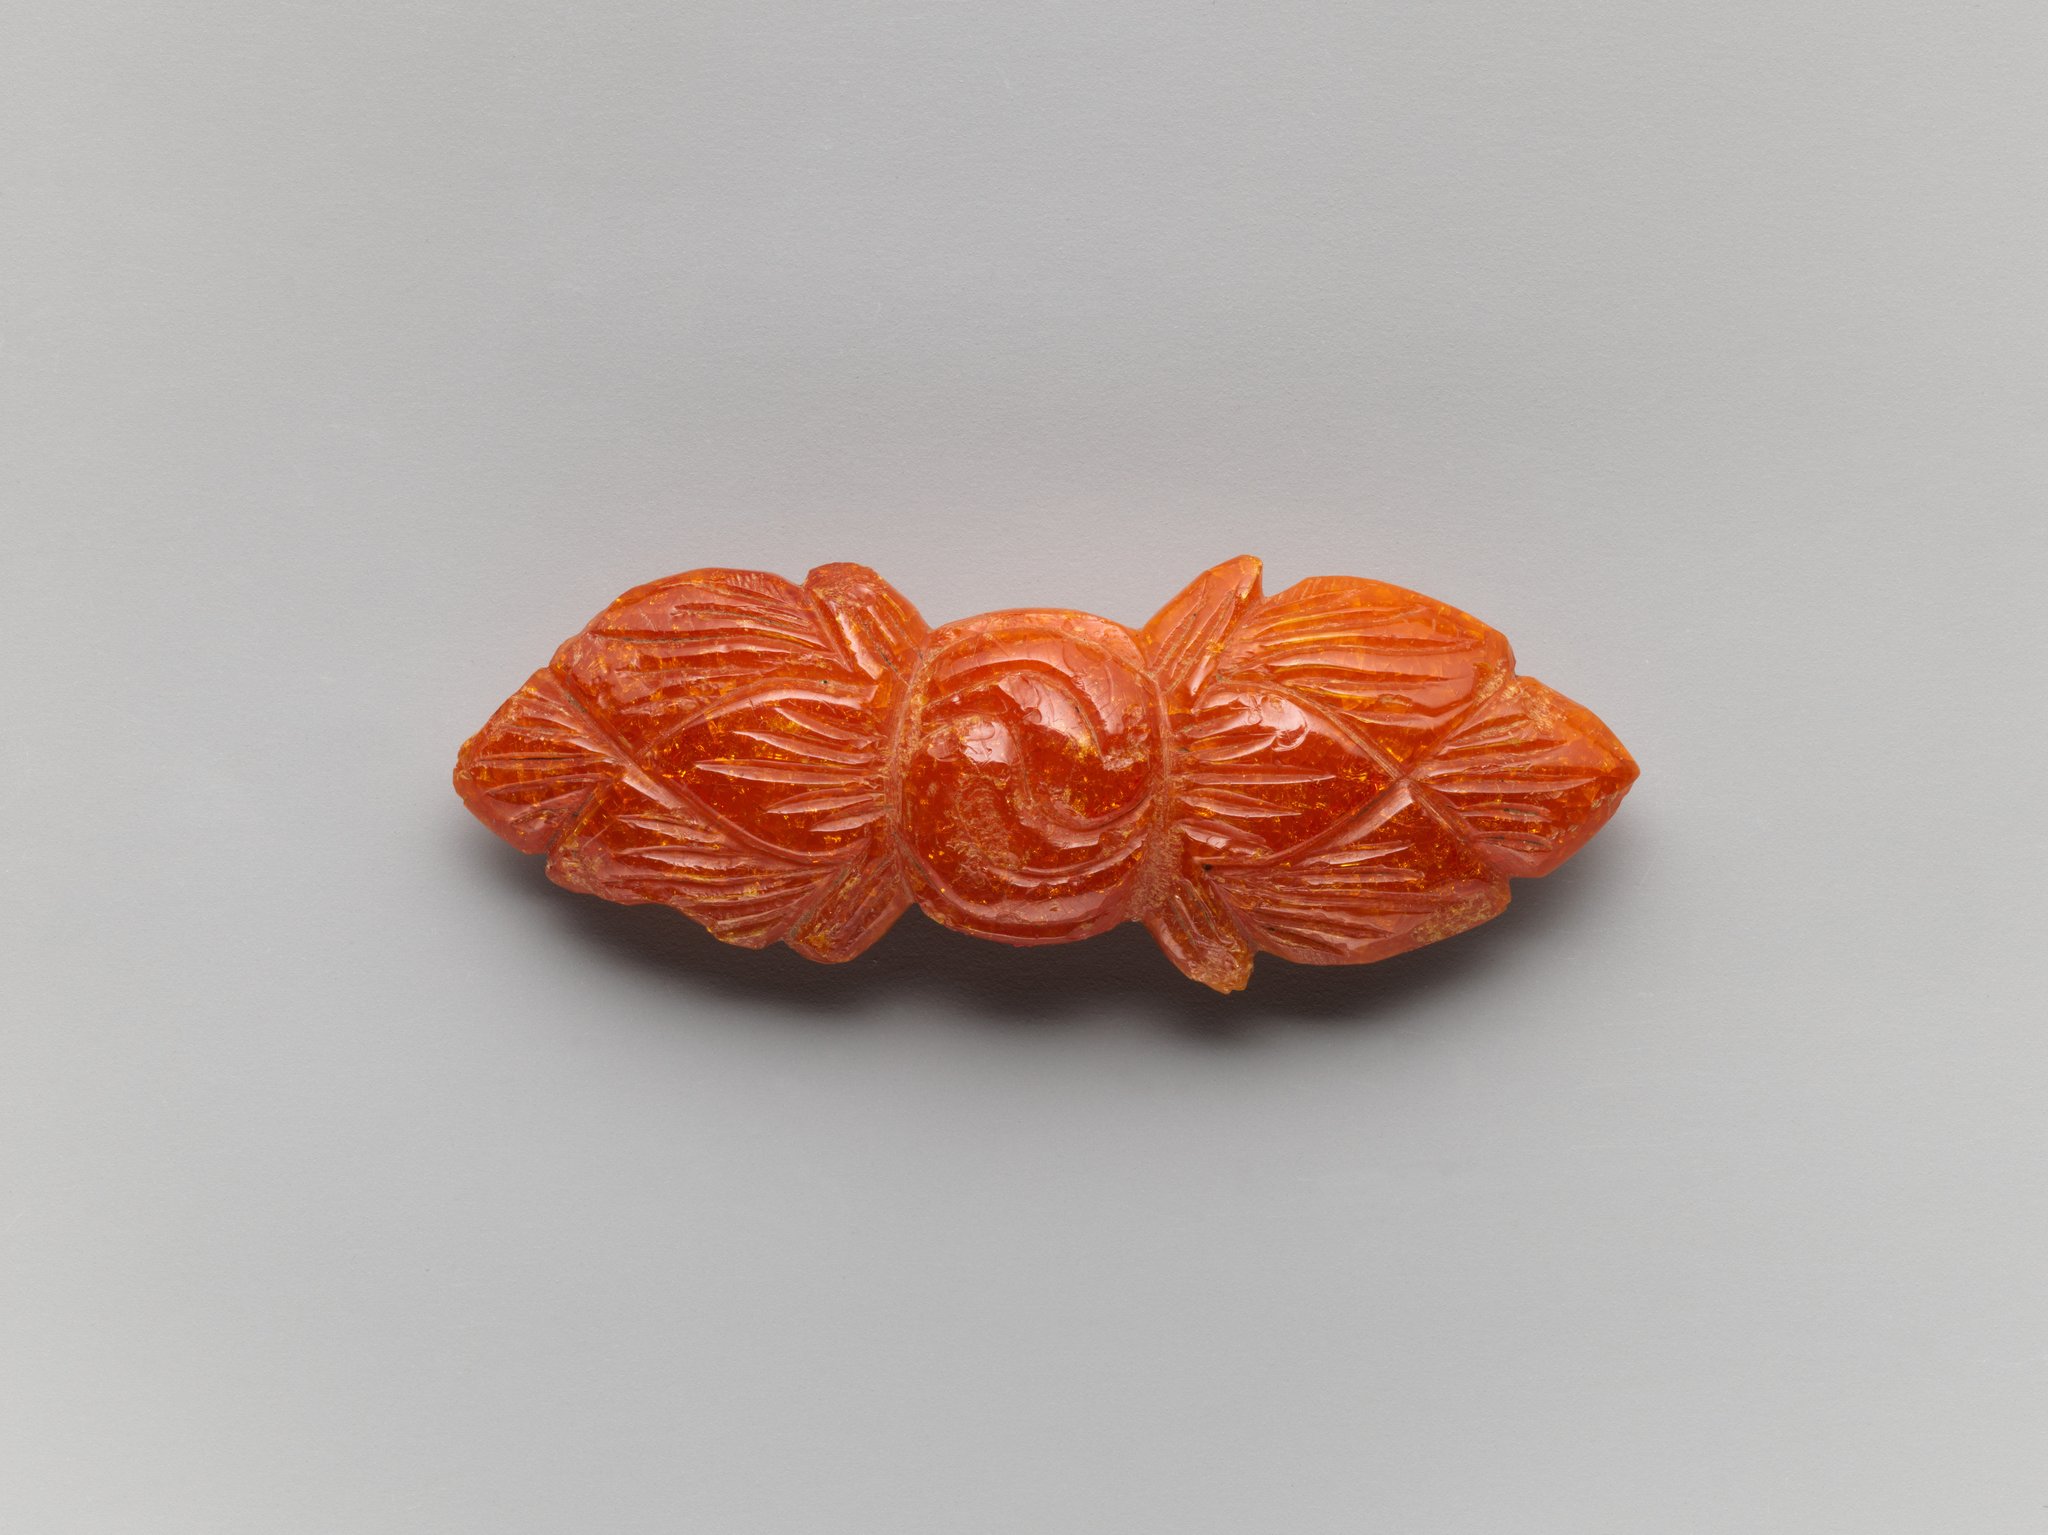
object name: ornament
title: Bow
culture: chinese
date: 1001-1100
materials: amber